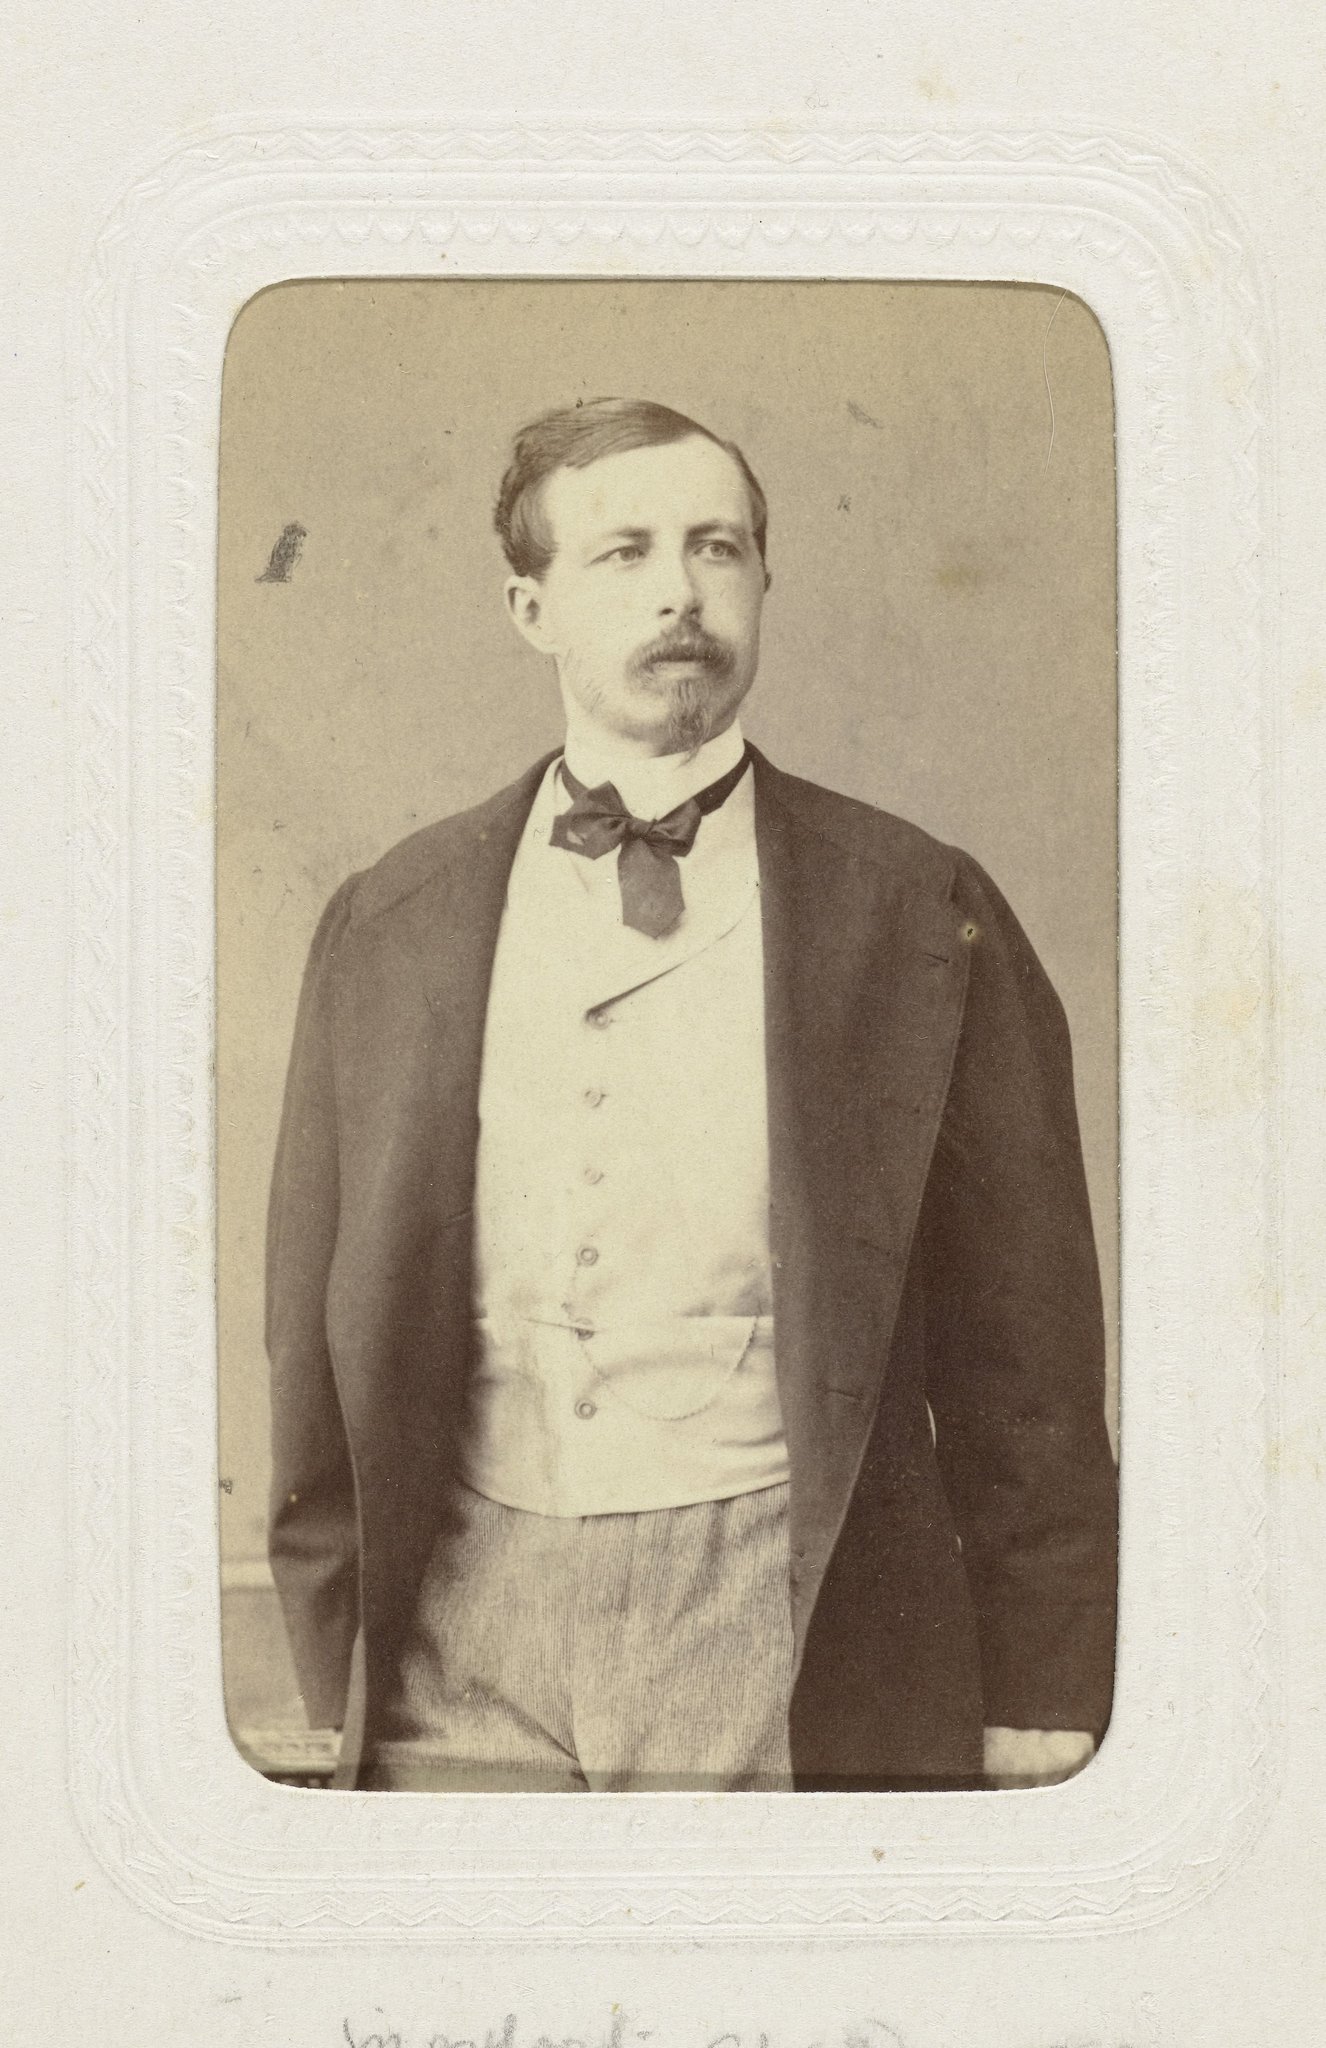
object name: carte de visite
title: Studioportret van een man met snor en baard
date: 1863-1866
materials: cardboard, paper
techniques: albumen print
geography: istanbul